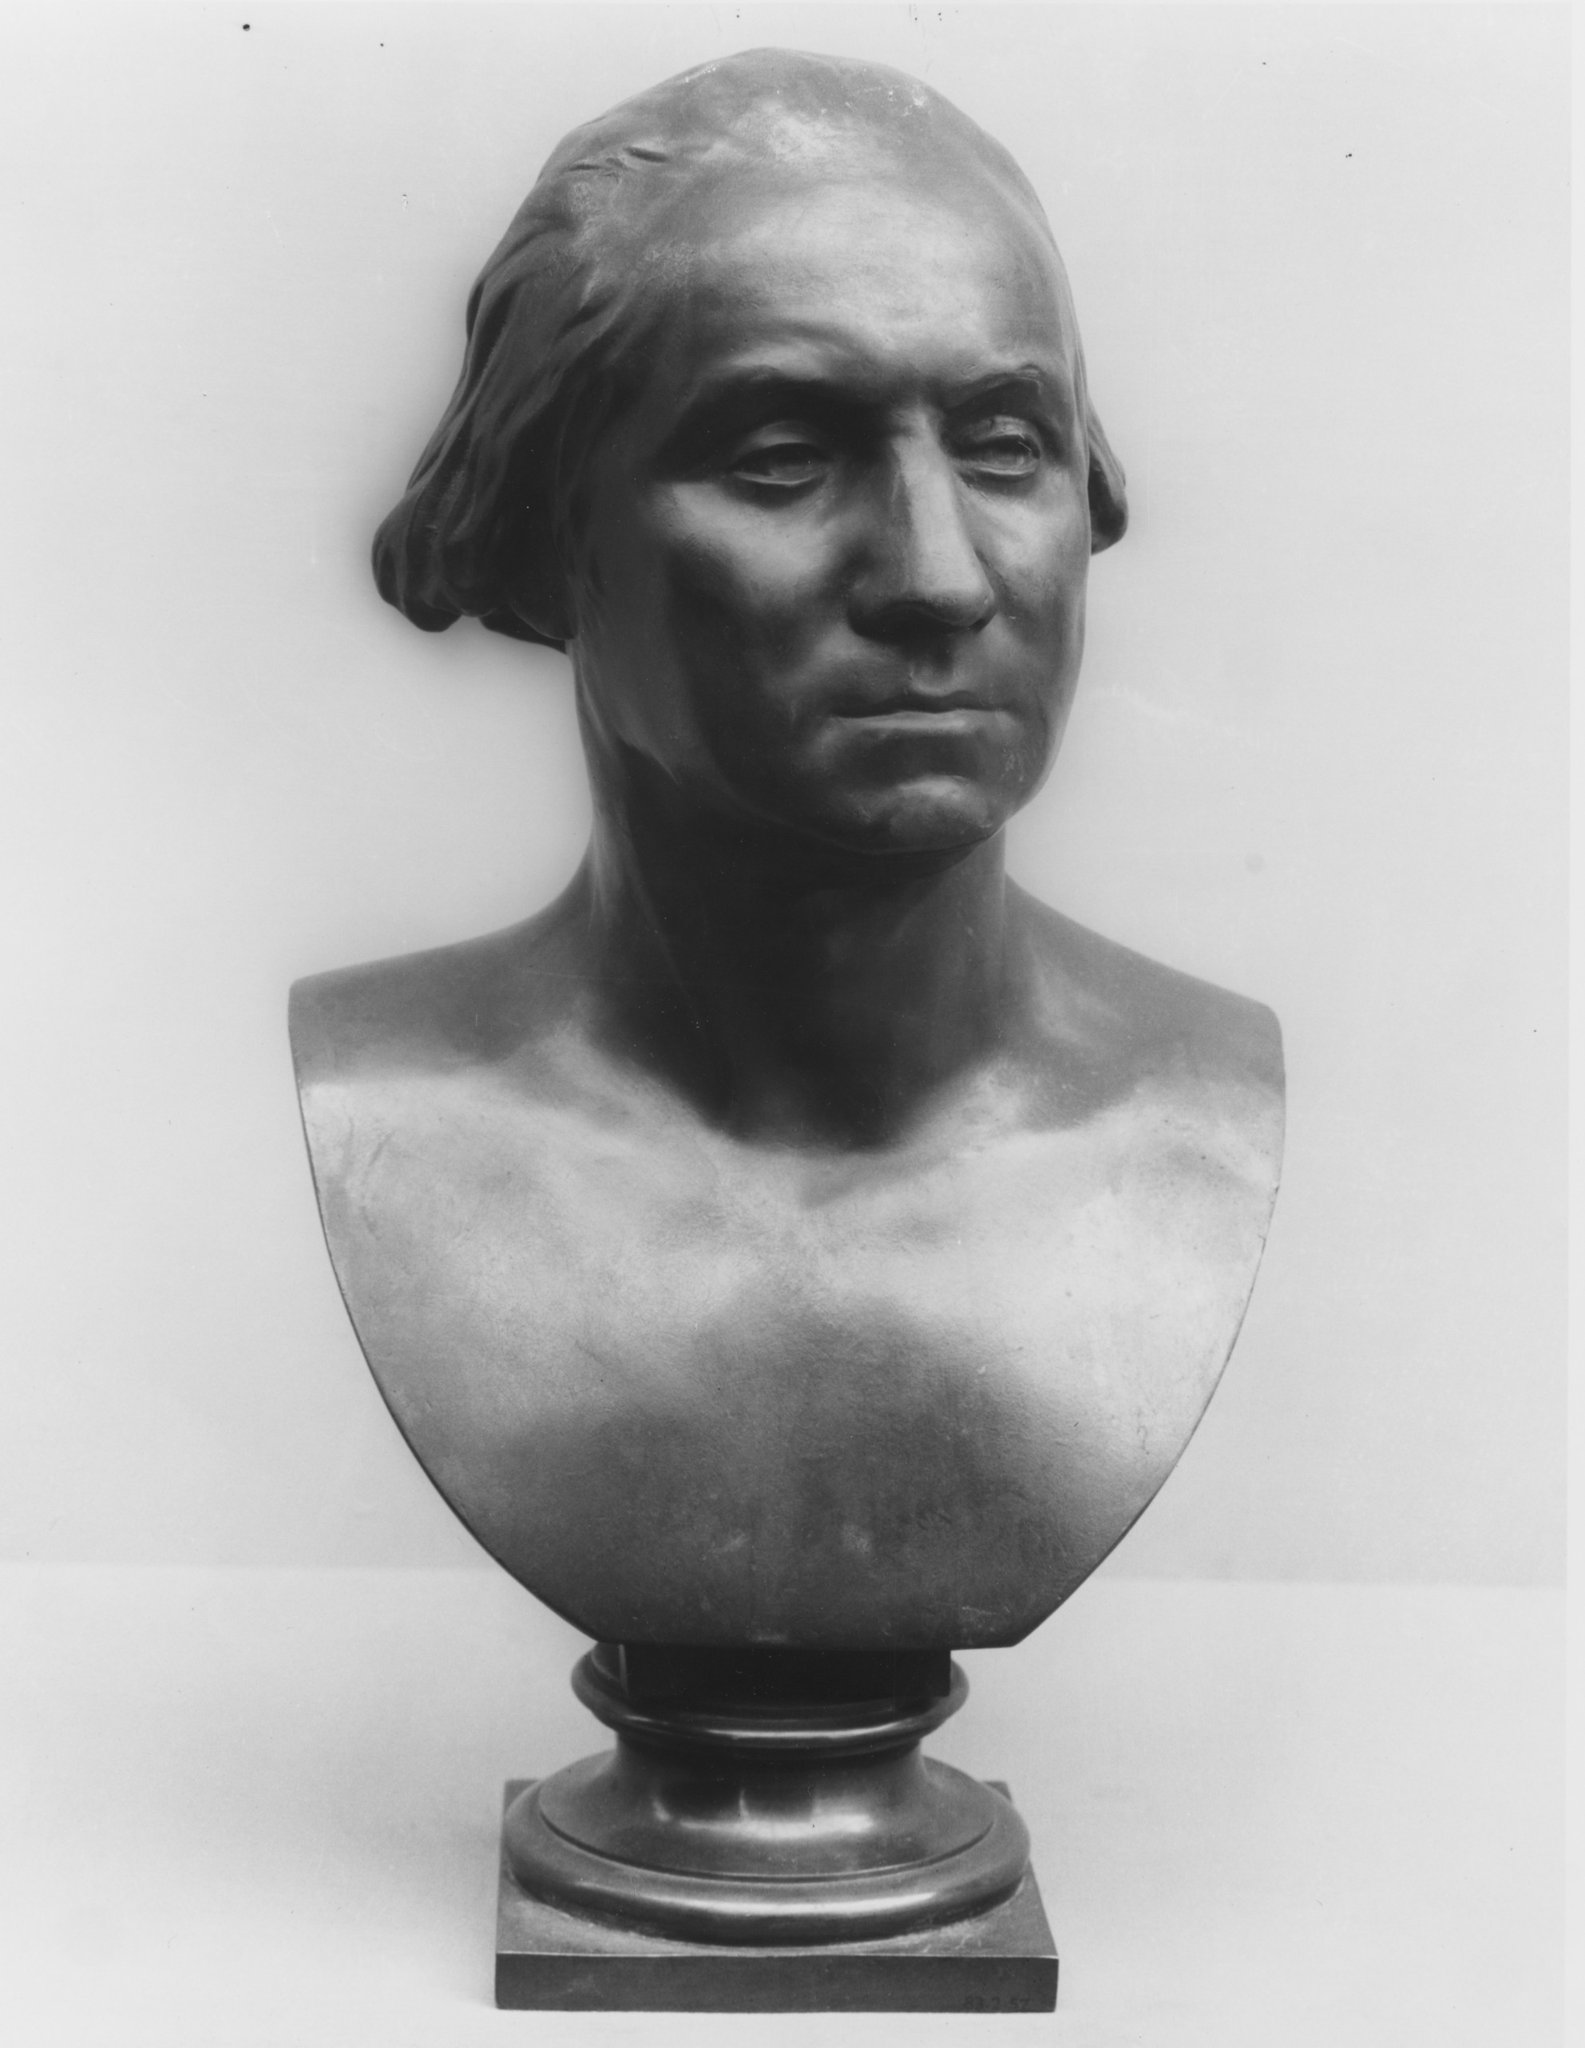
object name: bust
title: George Washington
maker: achille collas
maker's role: maker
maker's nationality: french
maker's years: 1795-1859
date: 1830-1883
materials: bronze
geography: france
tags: george washington,men,portraits